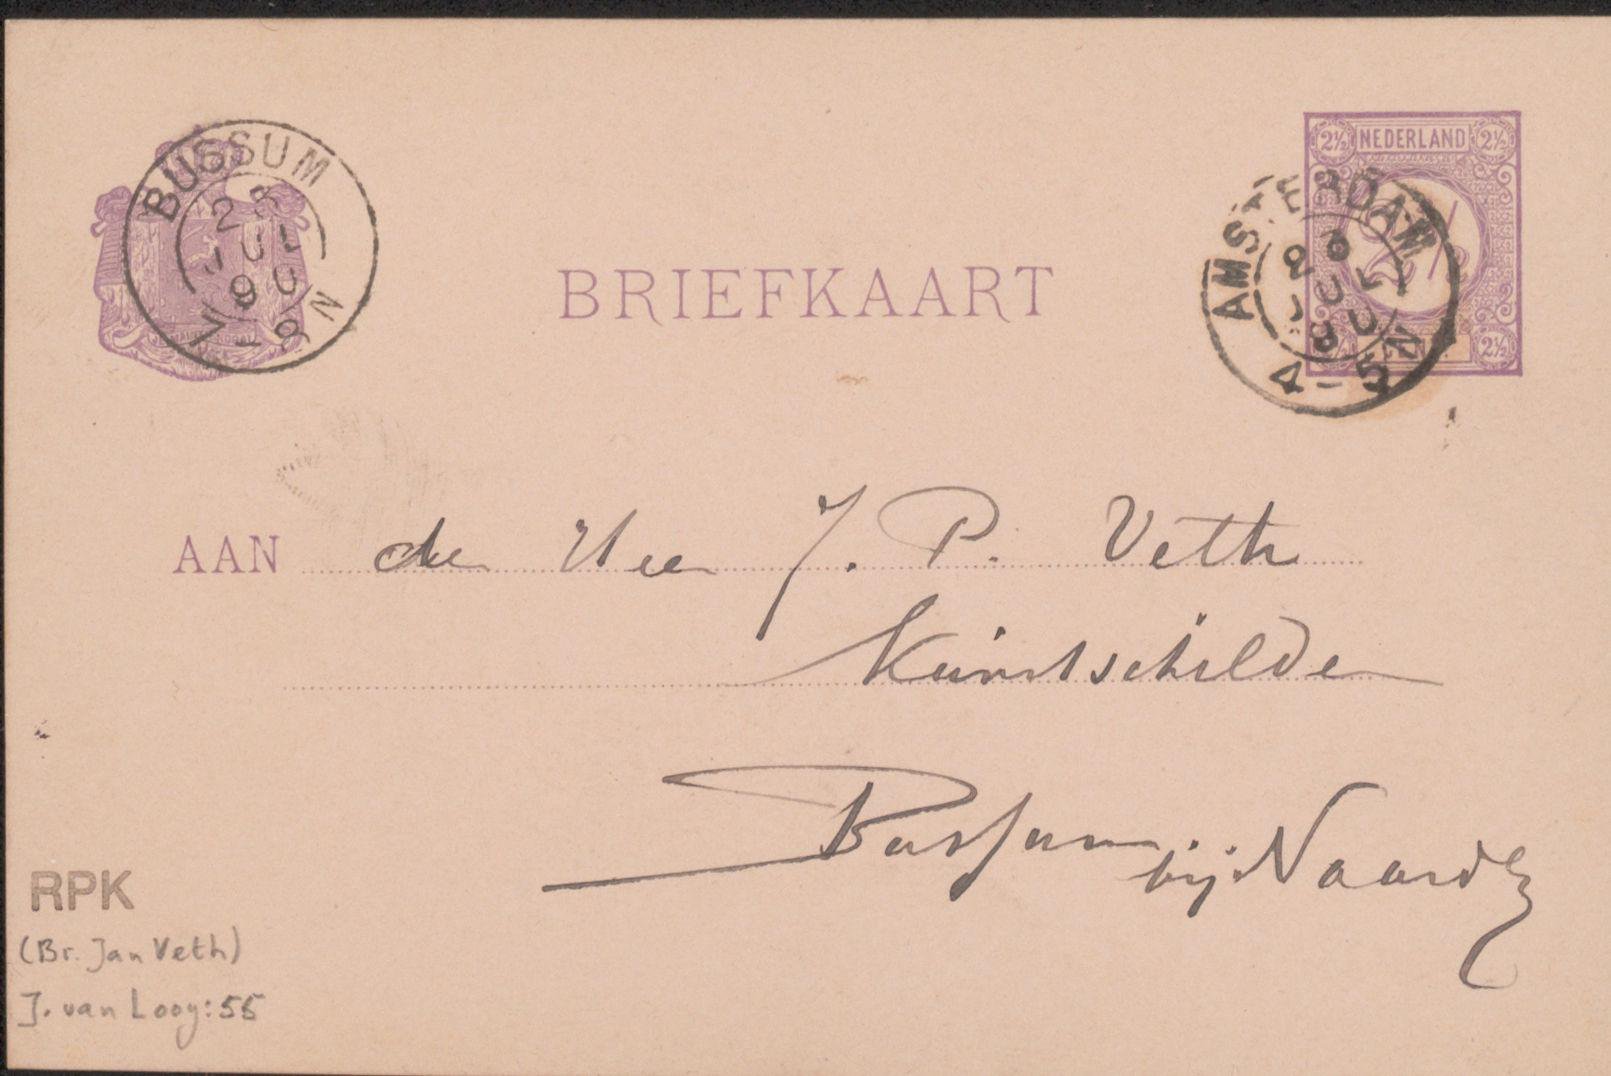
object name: postcard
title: Briefkaart aan Jan Veth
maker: jac van looij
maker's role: draughtsman, painter, print maker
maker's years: 1855-1930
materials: cardboard, ink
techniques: pen, writing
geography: amsterdam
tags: dordrecht, amsterdam, designer, jan veth, drawing, exhibition ~ art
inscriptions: collector's mark: ‘RPK’